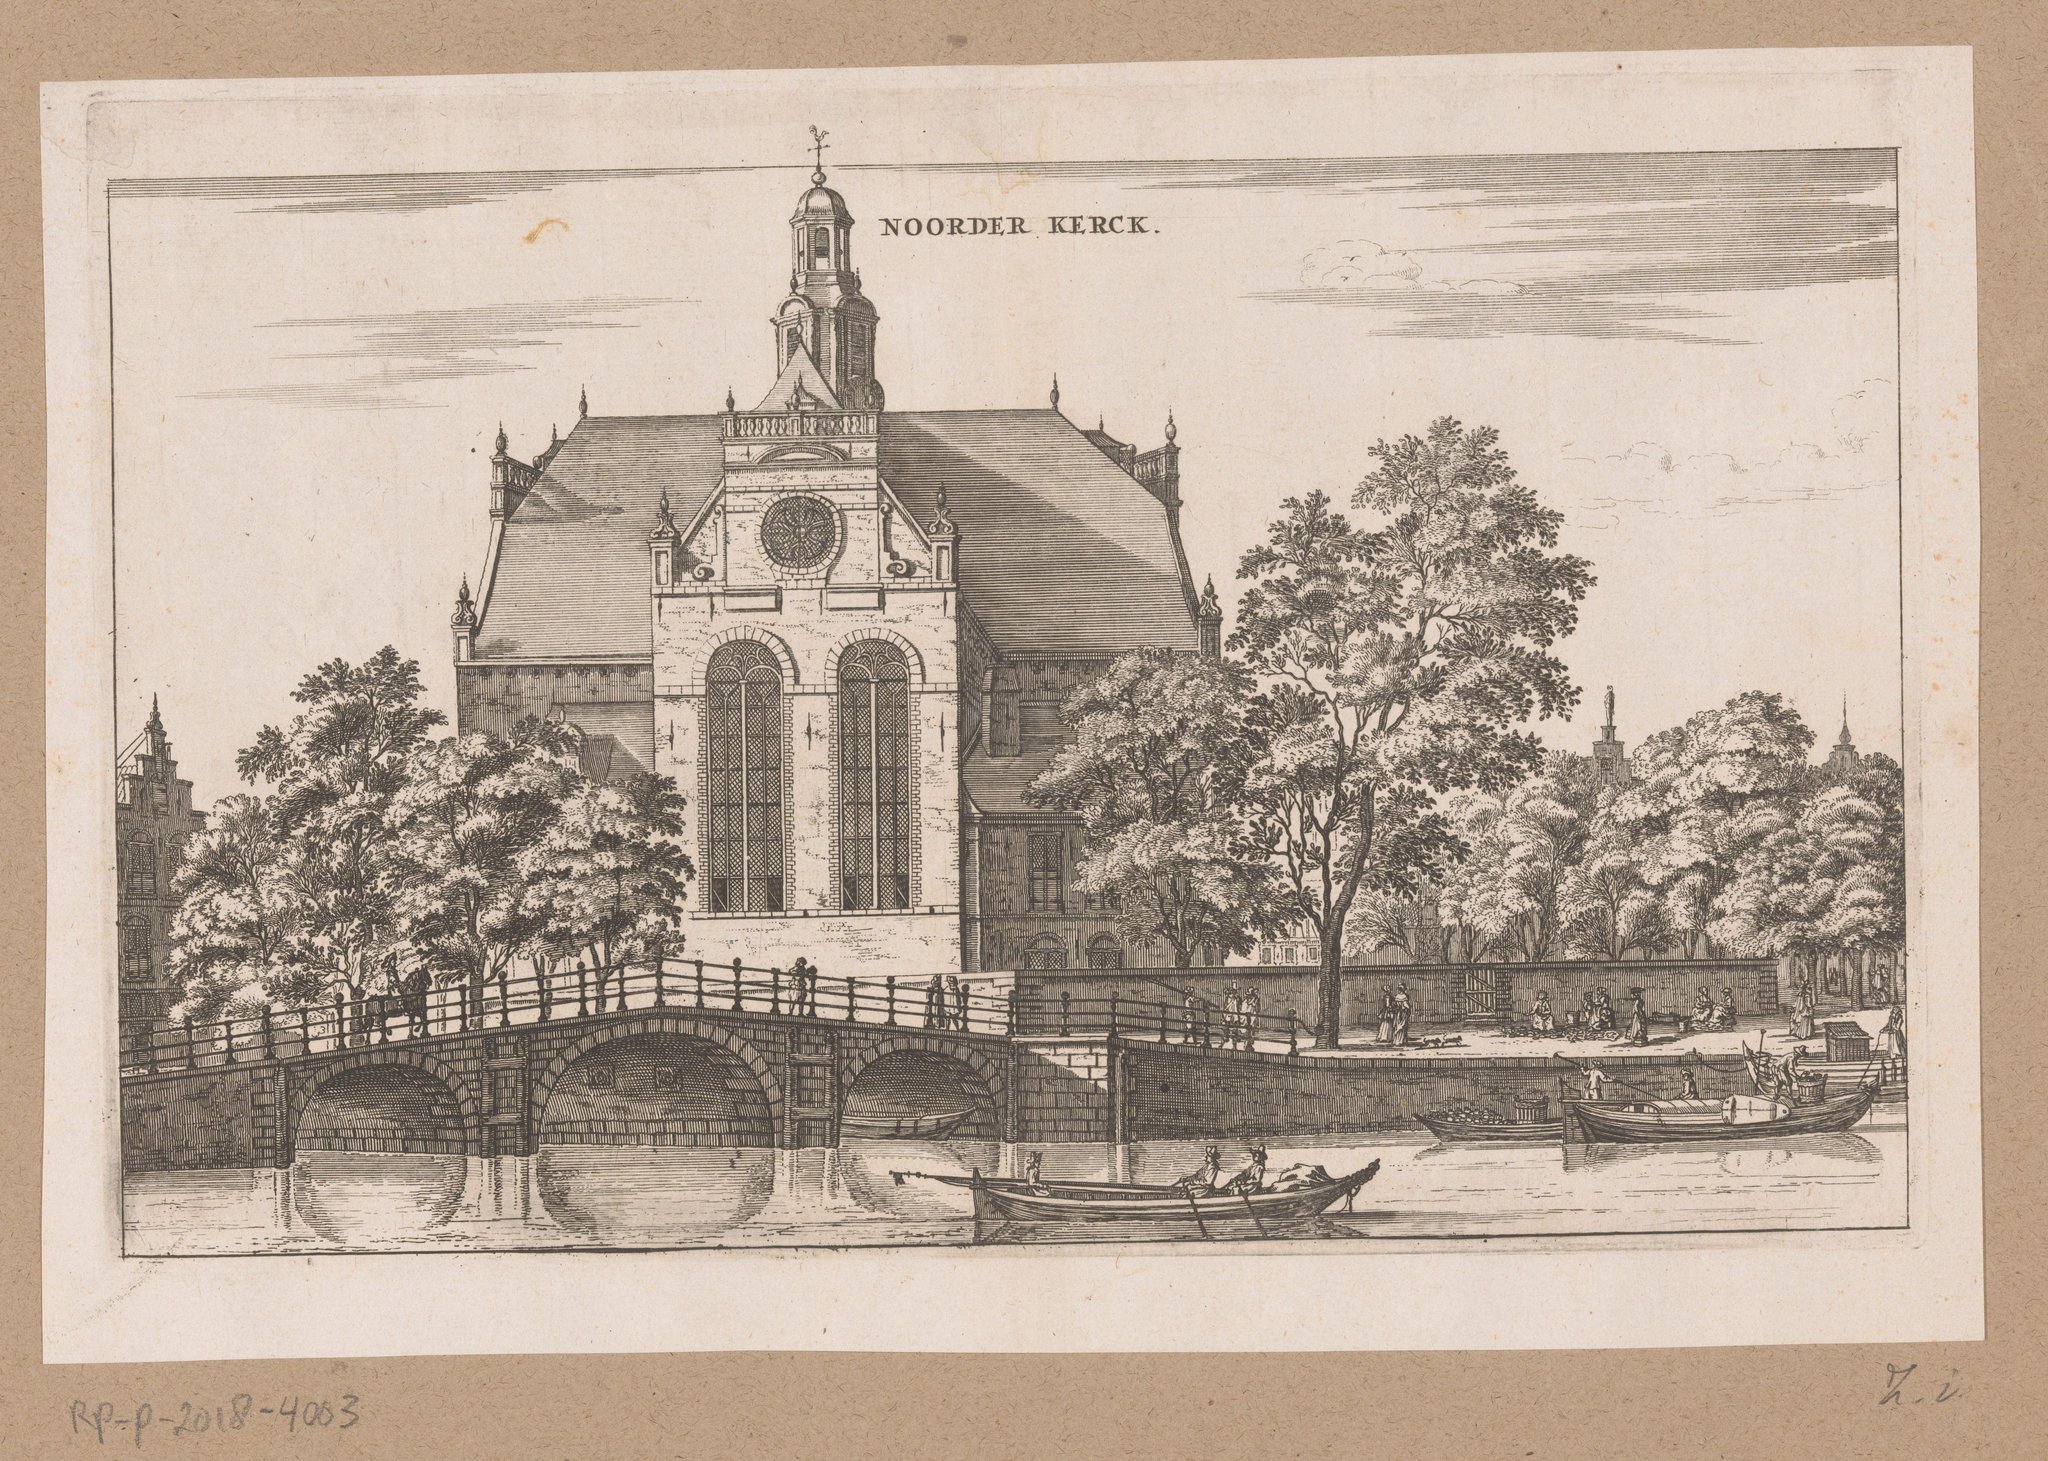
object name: print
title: Gezicht op de Noorderkerk te Amsterdam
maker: Anonymous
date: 1680-1720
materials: paper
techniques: etching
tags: bridge in city across river, canal, etc. (+ city(-scape) with figures, staffage), church (exterior), market